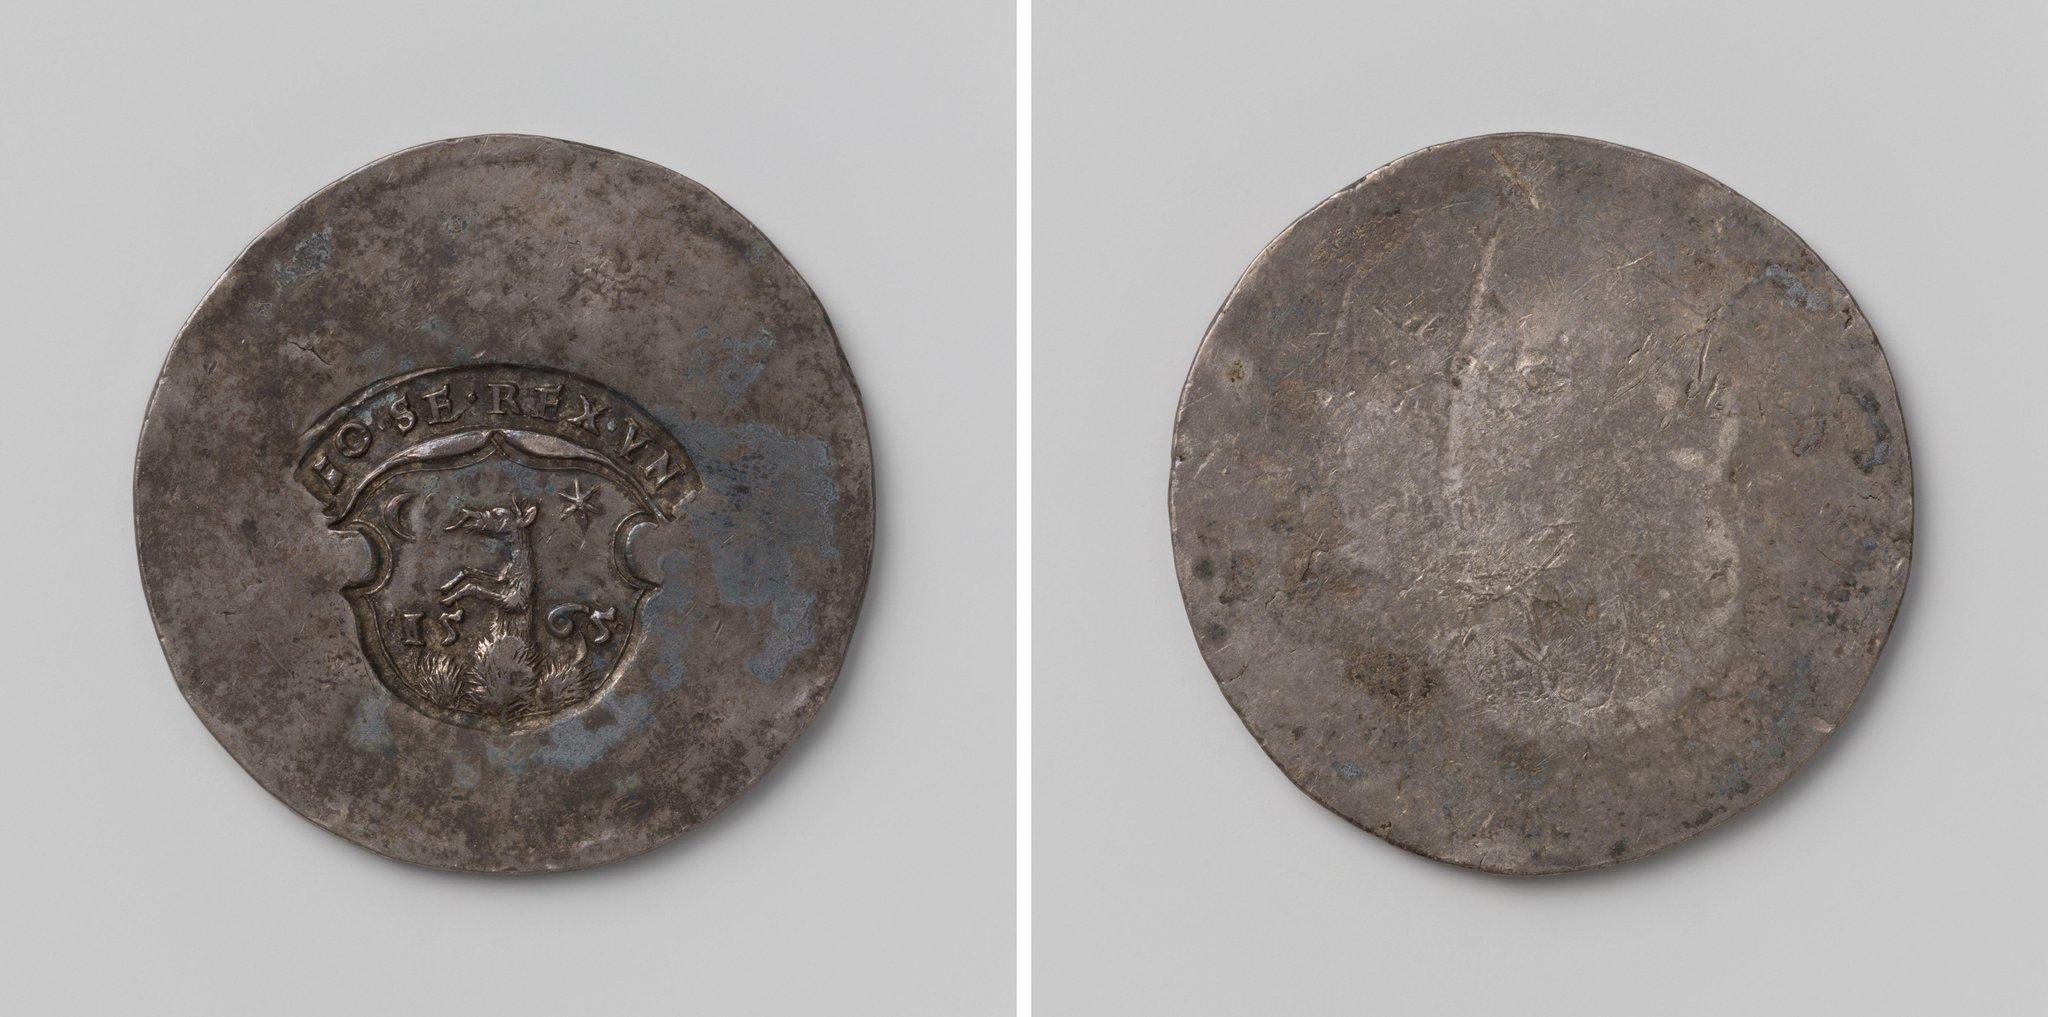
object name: coin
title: Taler, noodmunt voor het leger van Johan II Sigismund Zápolya, troonpretedent van Hongarije en prins van Transsylvanië, in oorlog tegen keizer Maximiliaan II.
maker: Anonymous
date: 1565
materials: silver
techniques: striking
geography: hungary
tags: vienna, maximiliaan ii (keizer van heilige roomse rijk)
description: eenzijdige noodmunt. Voorzijde: twee stempels: bovenste stempel: letters IO, SE, REX en VN in wimpel; onderste stempel: in cartouche: staand dier ten halven lijve tussen maan en ster en jaartal. Keerzijde: blanco